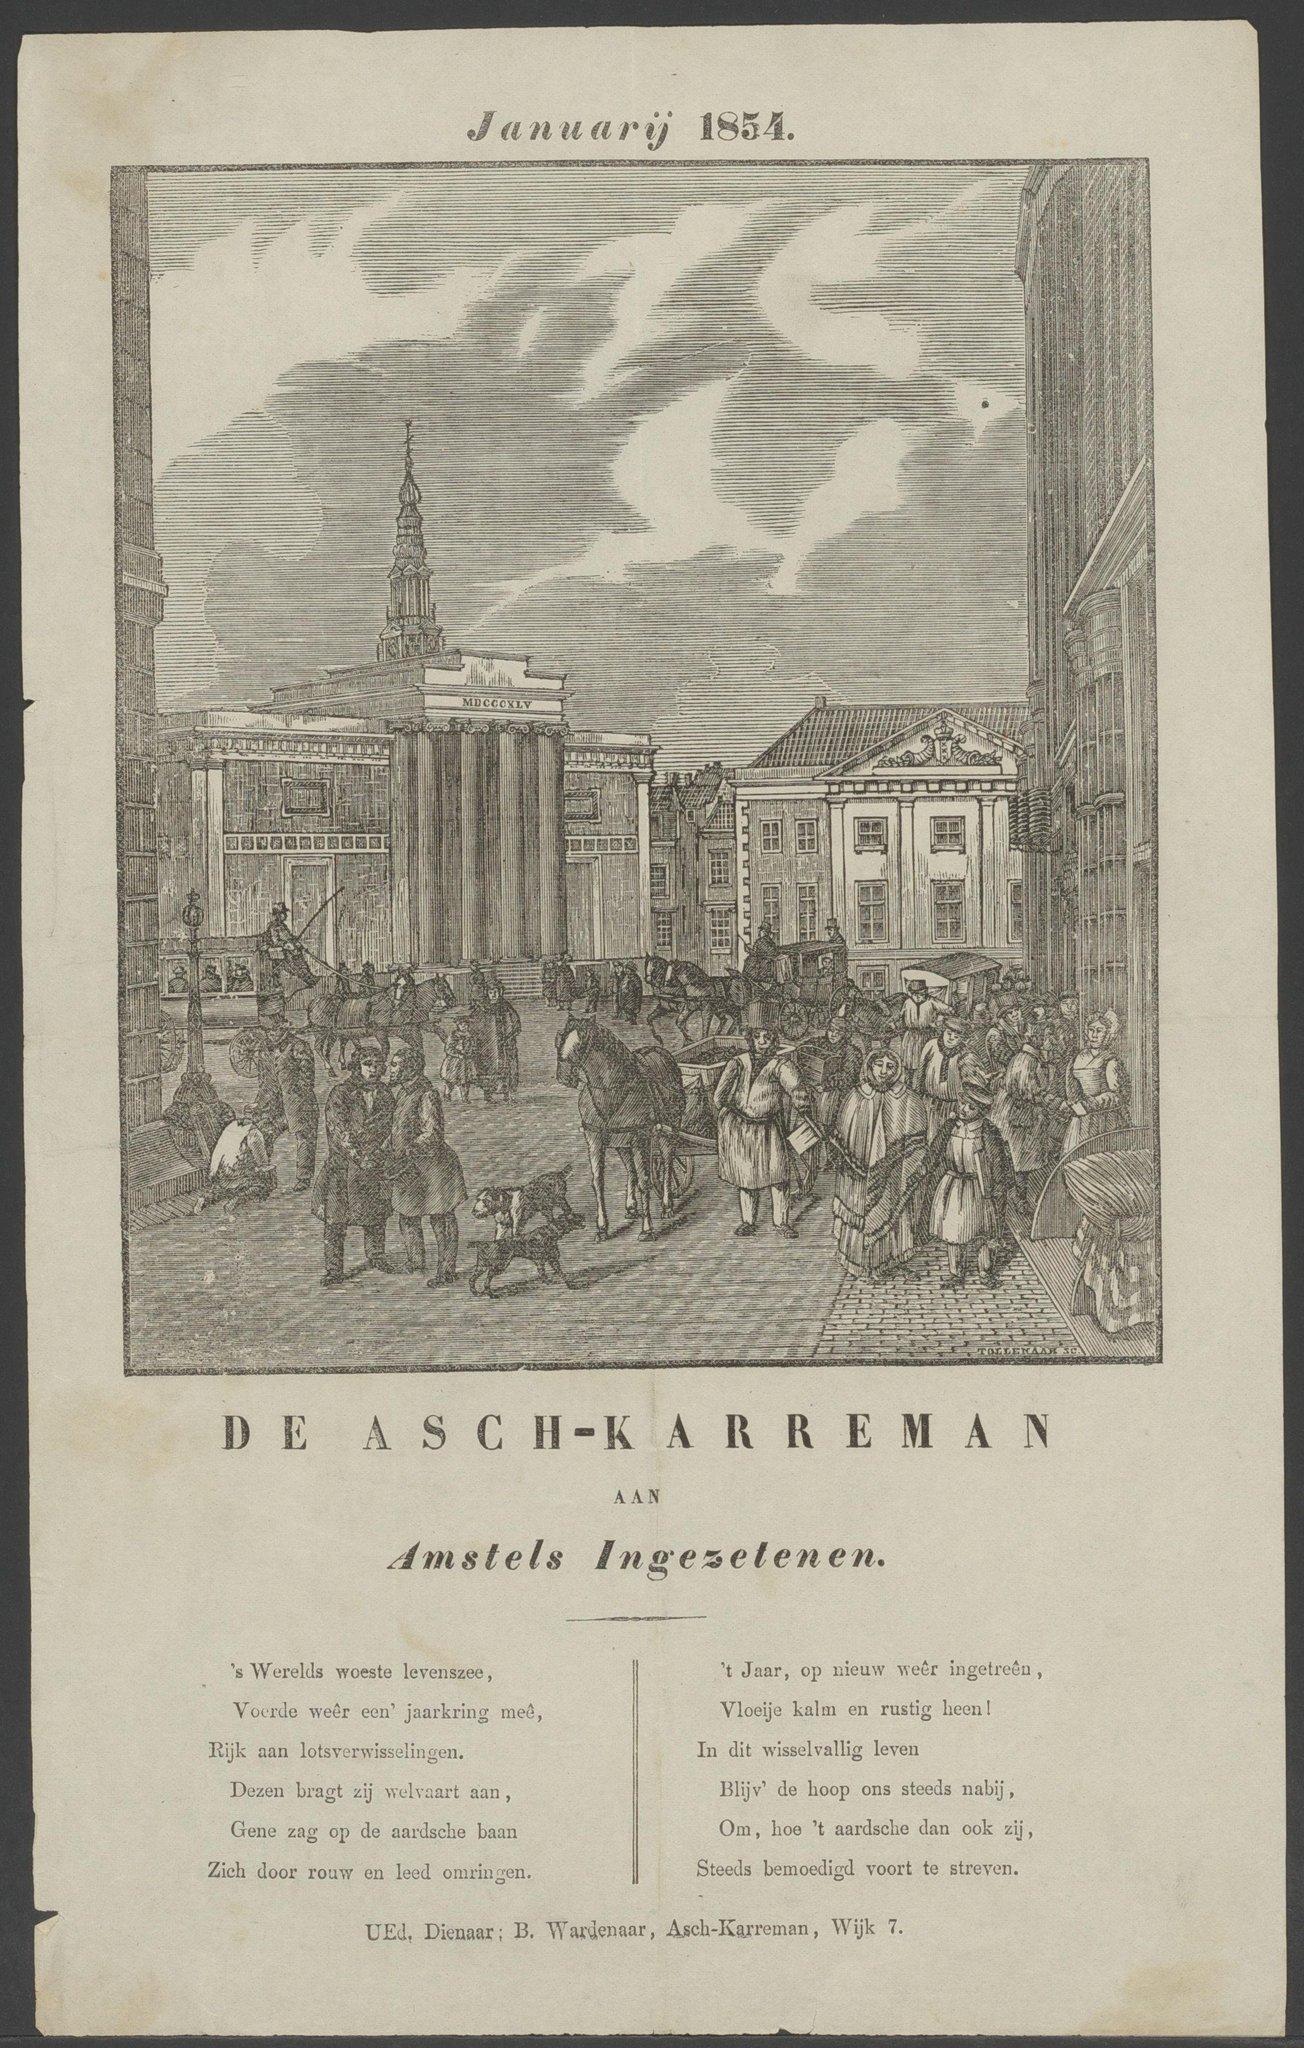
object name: new year card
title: Nieuwjaarswens van de askarrenmannen van Amsterdam voor het jaar 1854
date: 1853-1854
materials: paper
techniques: letterpress printing, engraving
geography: amsterdam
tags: street, garbage collection, amsterdam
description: Nieuwjaarswens van askarrenmannen (karrenman of vuilnisman) van Amsterdam voor het jaar 1854. Gezicht op de Dam met de Beurs van Zocher en het Commandantshuis te Amsterdam. Tussen het publiek de vuilnismannen met hun kar. Met gedicht in twee kolommen. Van de vuilniskarman in de wijk no. 7: B. Wardenaar. Onderwerpsrubrieken binnen de Atlas Zeden en Gewoonten: Zeden en gewoonten in engeren zin, Volksleven, Volksbladen, Nieuwjaars- en Kerstwenschen, Amsterdam.